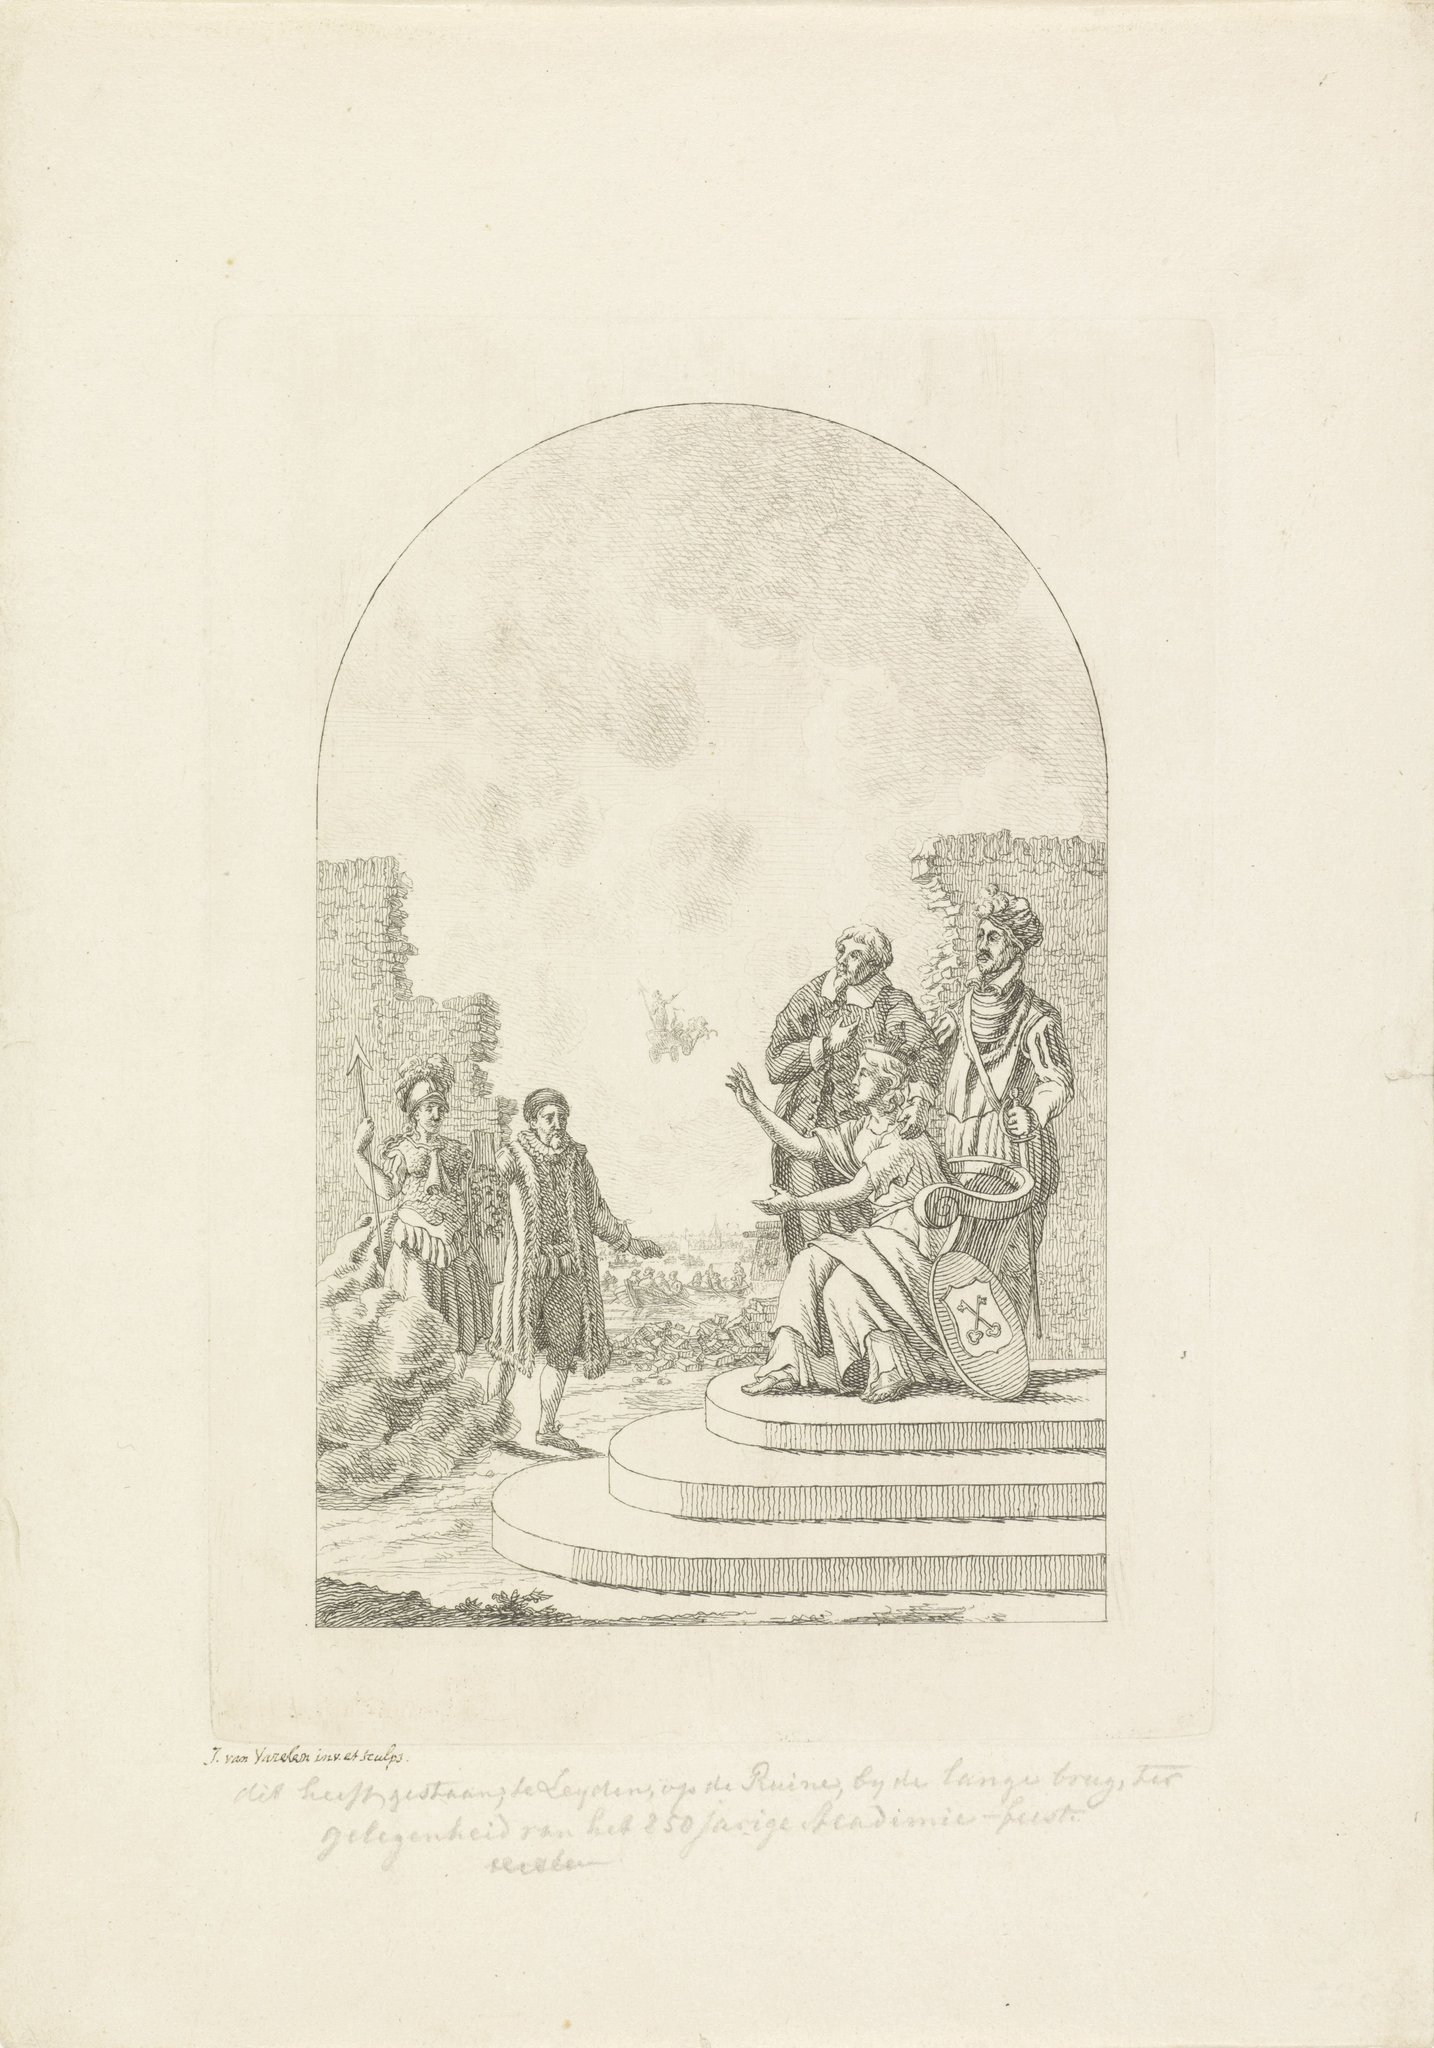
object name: print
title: Chassinet met Willem van Oranje en Minerva voor de Leidse stedenmaagd, bij het 250-jarige Academiefeest te Leiden, 1825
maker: jacob elias van varelen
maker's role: draughtsman, print maker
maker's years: 1757-1840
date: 1825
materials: paper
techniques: etching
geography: netherlands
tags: delft, william i (prince of orange), mayor, minerva as patroness, personification of a city, town-patron(ess), leiden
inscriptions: collector's mark: Lugt 2228, name: ‘J. van Varelen inv. et sculps.’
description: Willem van Oranje en Minerva staande voor de stedenmaagd van Leiden die van haar troon probeert op te staan om de twee te begroeten. Achter haar twee staande mannen: Johan van der Does en burgemeester Pieter van der Werff. Tegen een achtergrond van een doorgebroken bakstenen muur. Door de muur zicht op boten op het water waarmee voedsel naar de stad wordt gebracht tijdens het ontzet van Leiden. In de lucht vertrekt Mars in zijn strijdwagen. Deze voorstelling stond afgebeeld op een chassinet opgesteld op de ruïne bij de Langebrug te Leiden ter gelegenheid van het 250-jarige Academiefeest op 8 februari 1825 (van de inwijding van Universiteit van Leiden, 8 februari 1575).